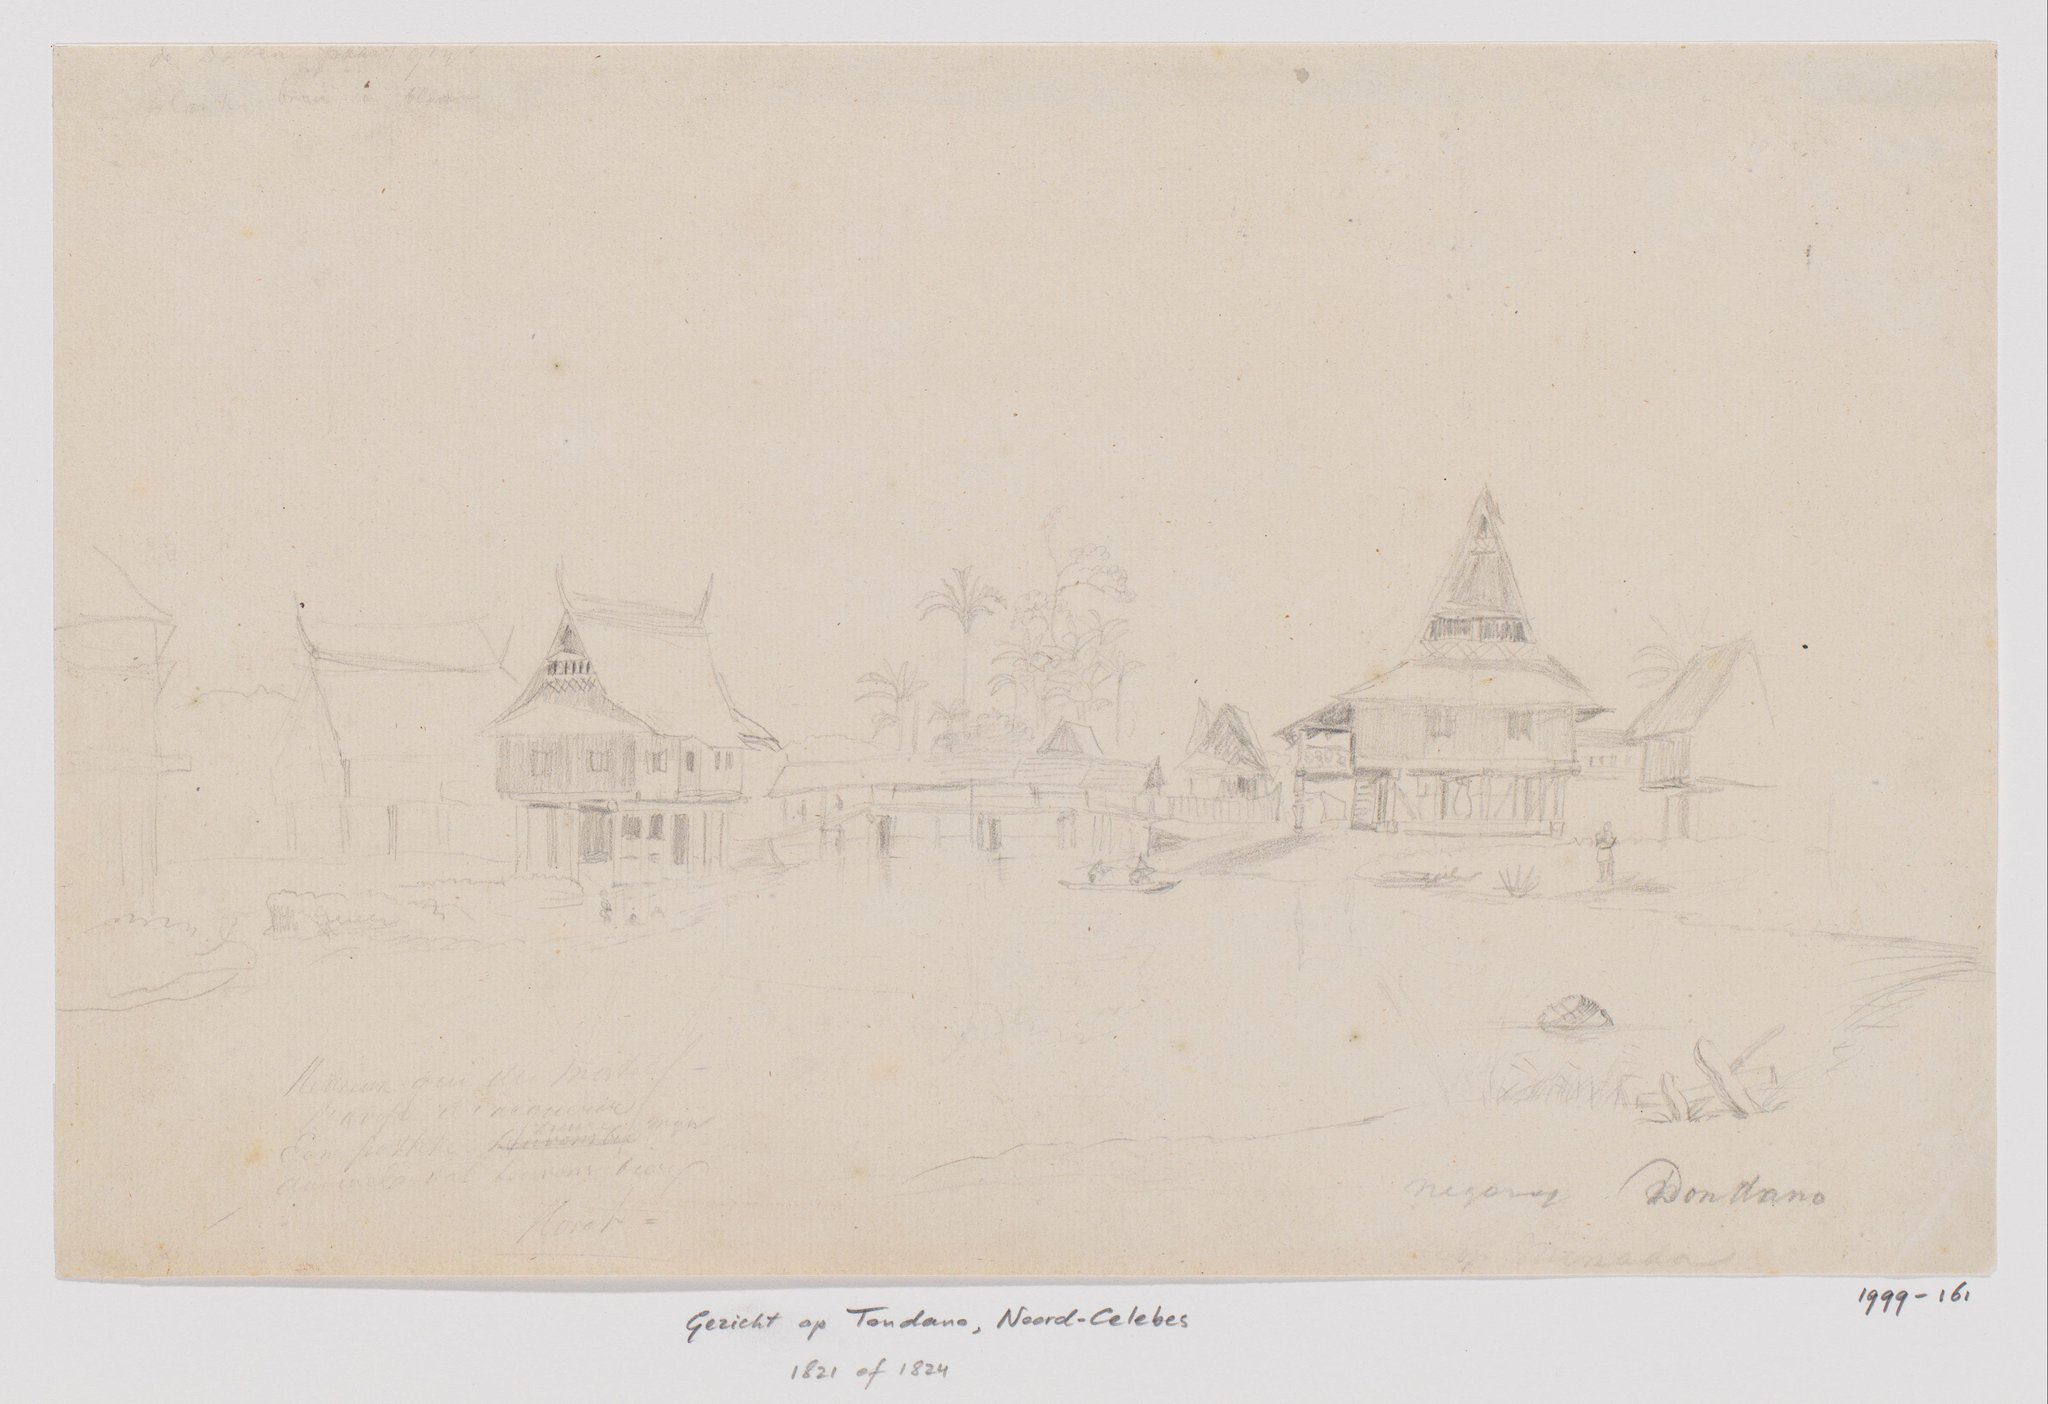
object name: drawing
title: Gezicht op Tondano, Noord-Celebes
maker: adrianus johannes bik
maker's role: draughtsman, print maker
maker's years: 1790-1872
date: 1821-1824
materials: paper, pencil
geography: north celebes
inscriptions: annotation: ‘negorij Dondano / op Manado’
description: artikel over deze collectie in Bulletin van het Rijksmuseum 49 [2001], nr. 4, pp.343 e.v.